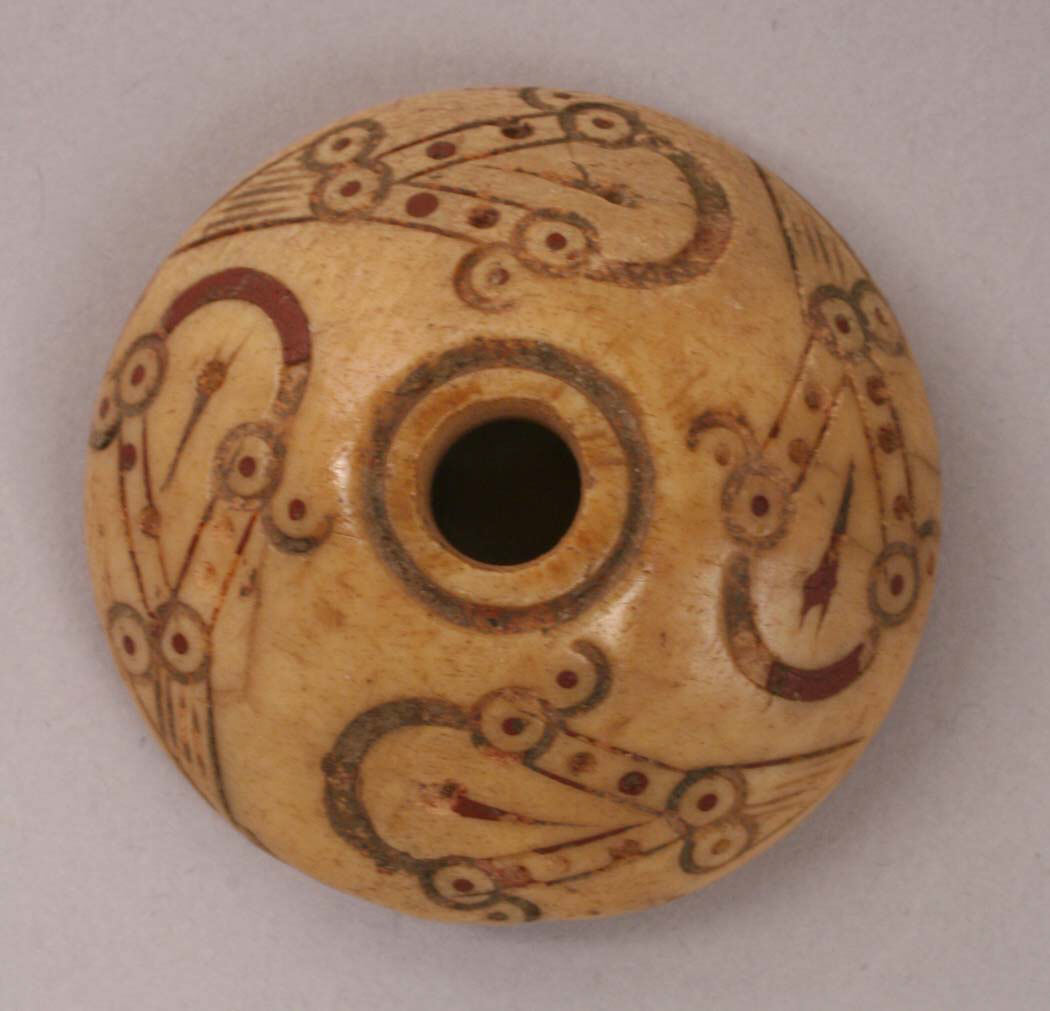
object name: spindle whorl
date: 701-1000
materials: bone, paint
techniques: incising, inlay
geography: egypt